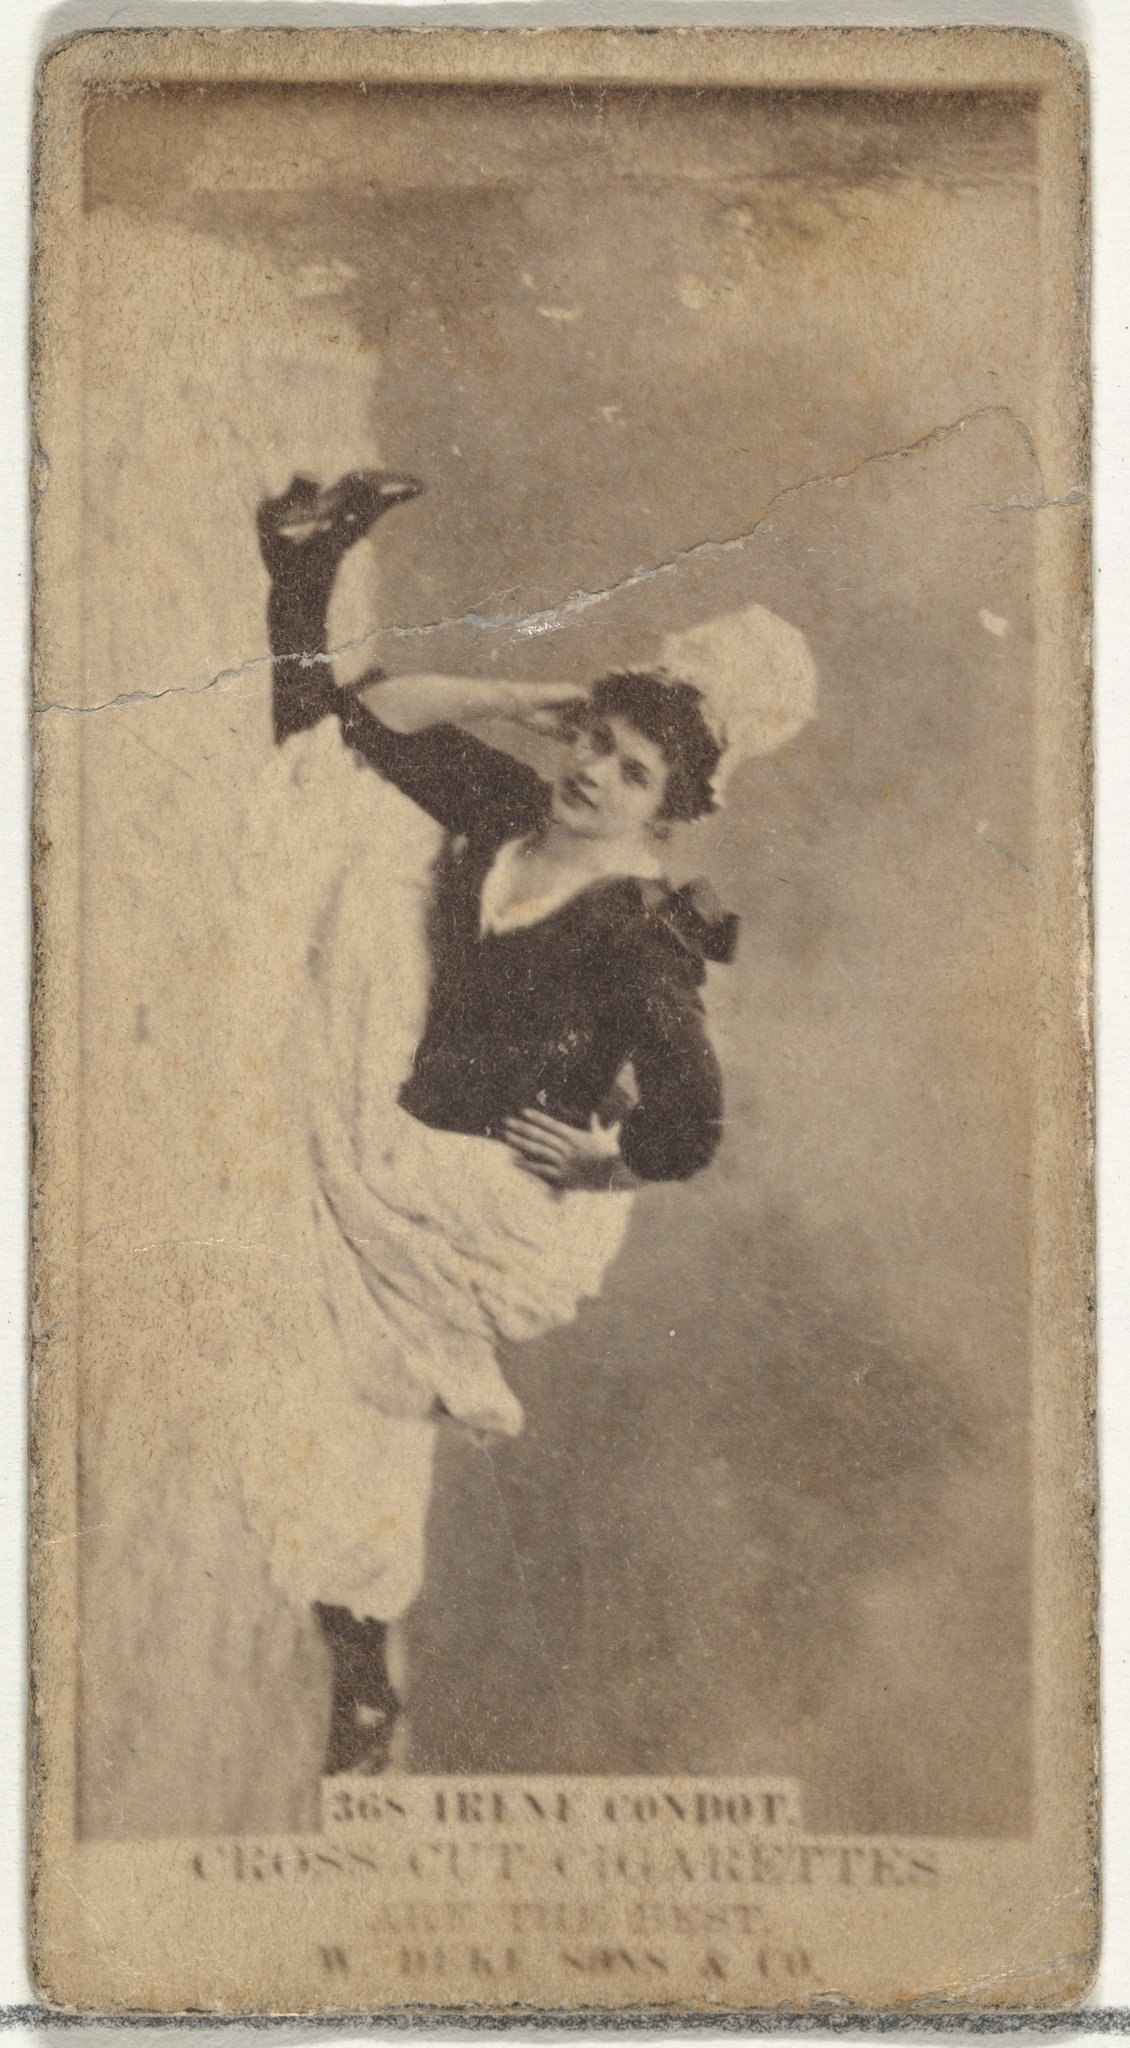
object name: photograph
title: Card Number 368, Irene Condot, from the Actors and Actresses series (N145-3) issued by Duke Sons & Co. to promote Cross Cut Cigarettes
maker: w. duke, sons & co.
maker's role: publisher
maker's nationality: american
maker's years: 1870-1920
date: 1880-1889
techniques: albumen silver print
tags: portraits,women,actresses